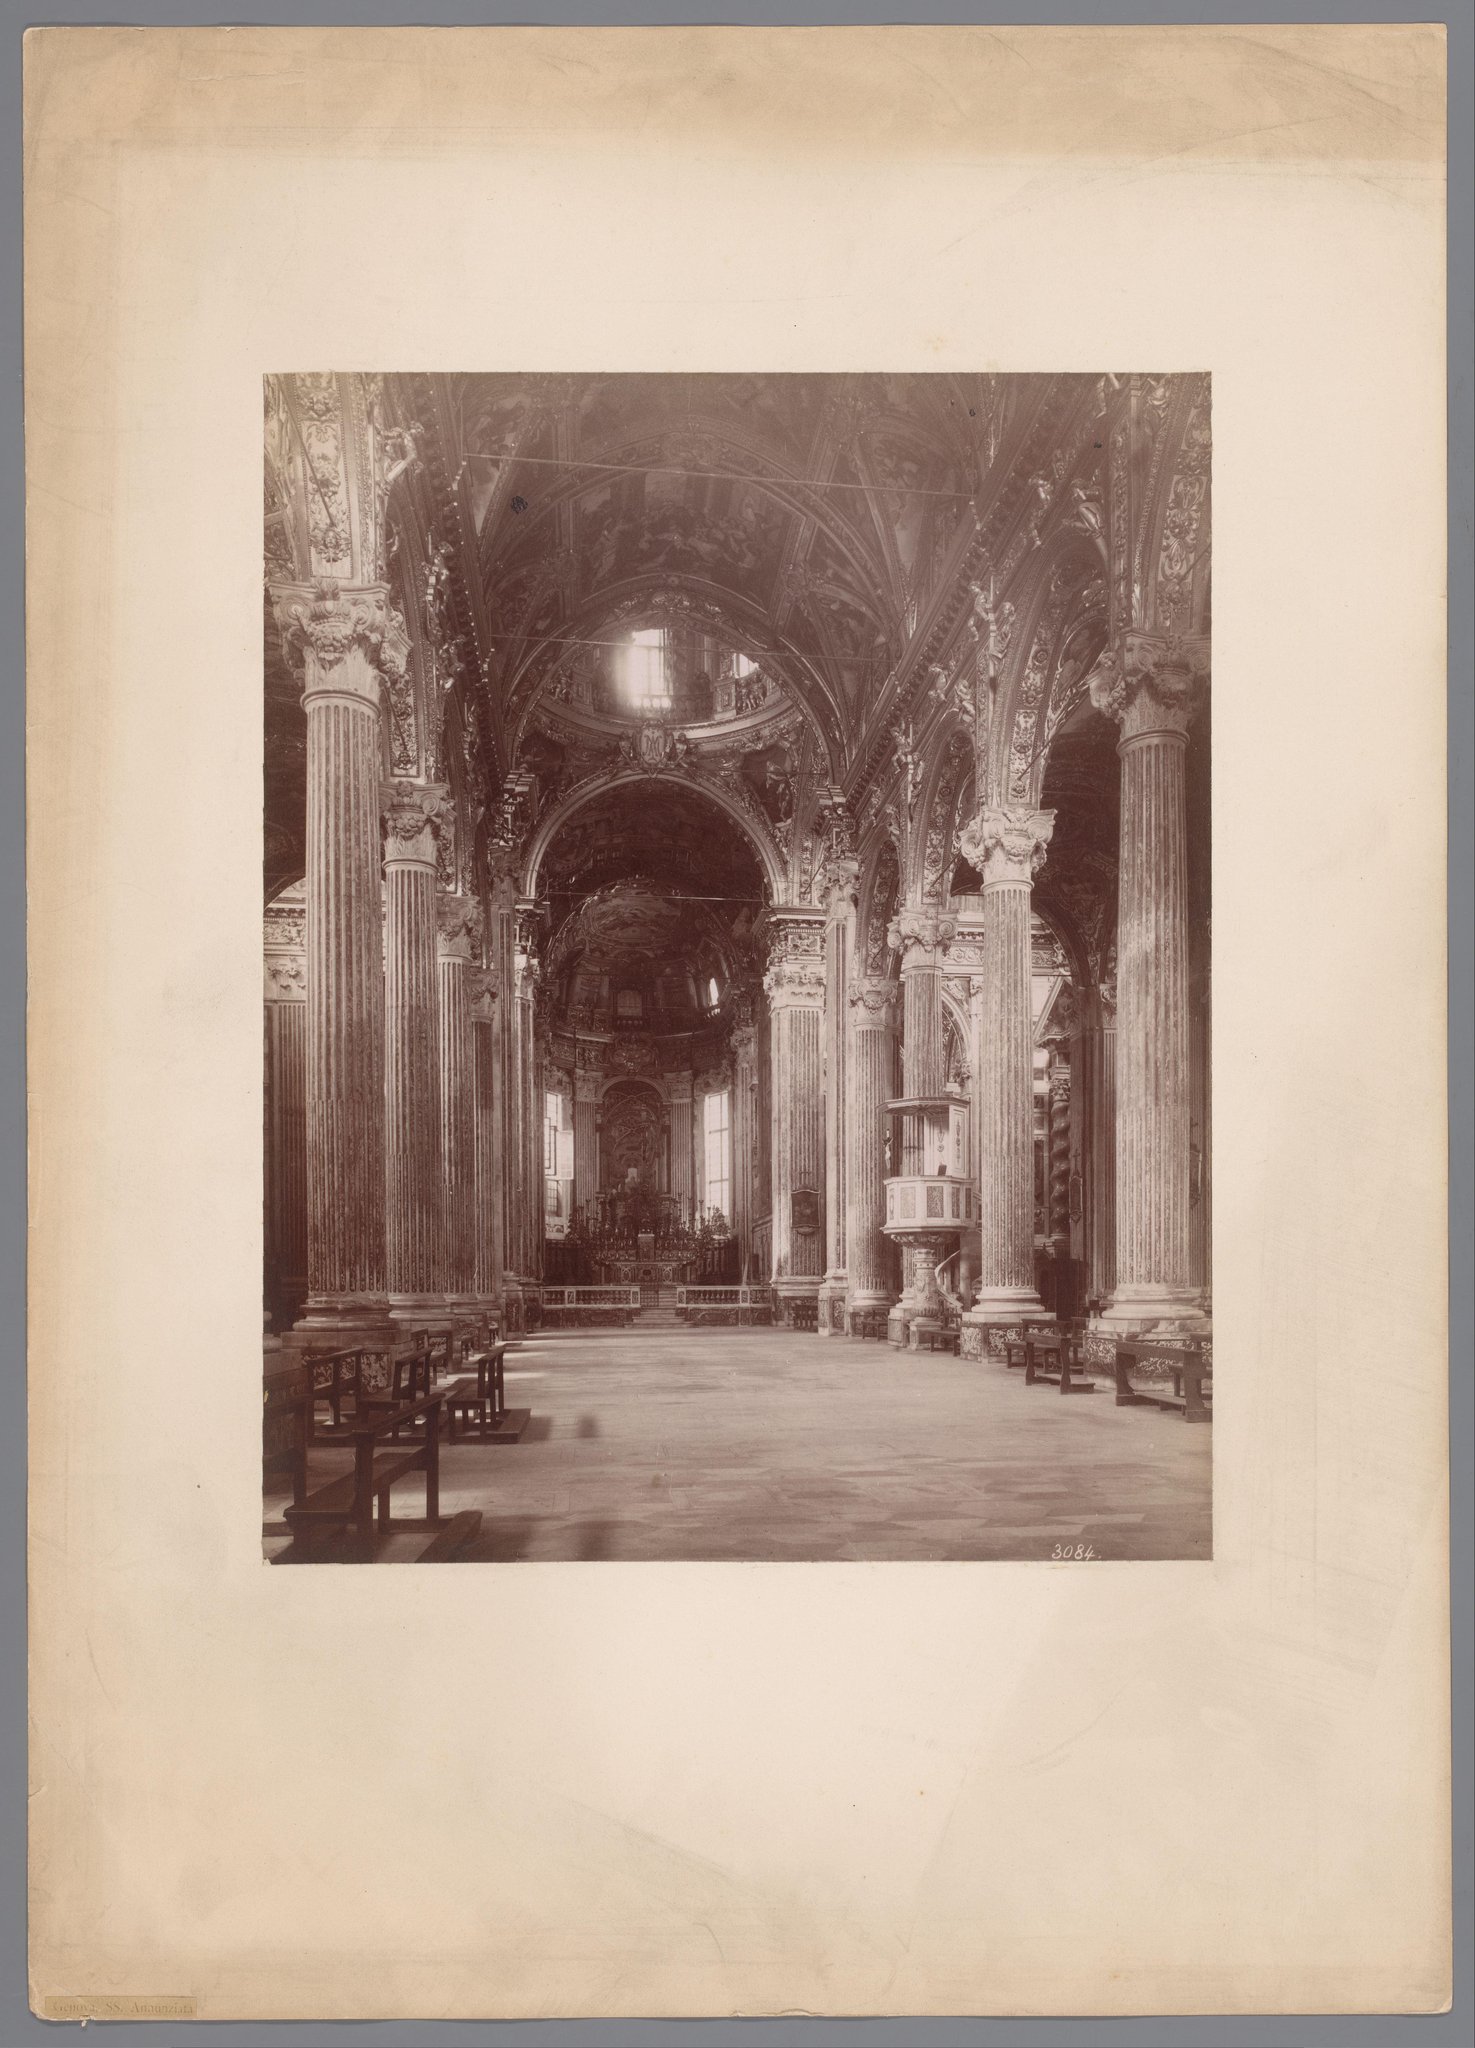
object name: photograph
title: SS Annunziata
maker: alfredo noack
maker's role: fotograaf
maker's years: 1833-1895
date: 1858-1893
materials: cardboard, paper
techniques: albumen print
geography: genoa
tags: interior of church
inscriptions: inscription: ‘Noack (t)’, number: ‘3084.’